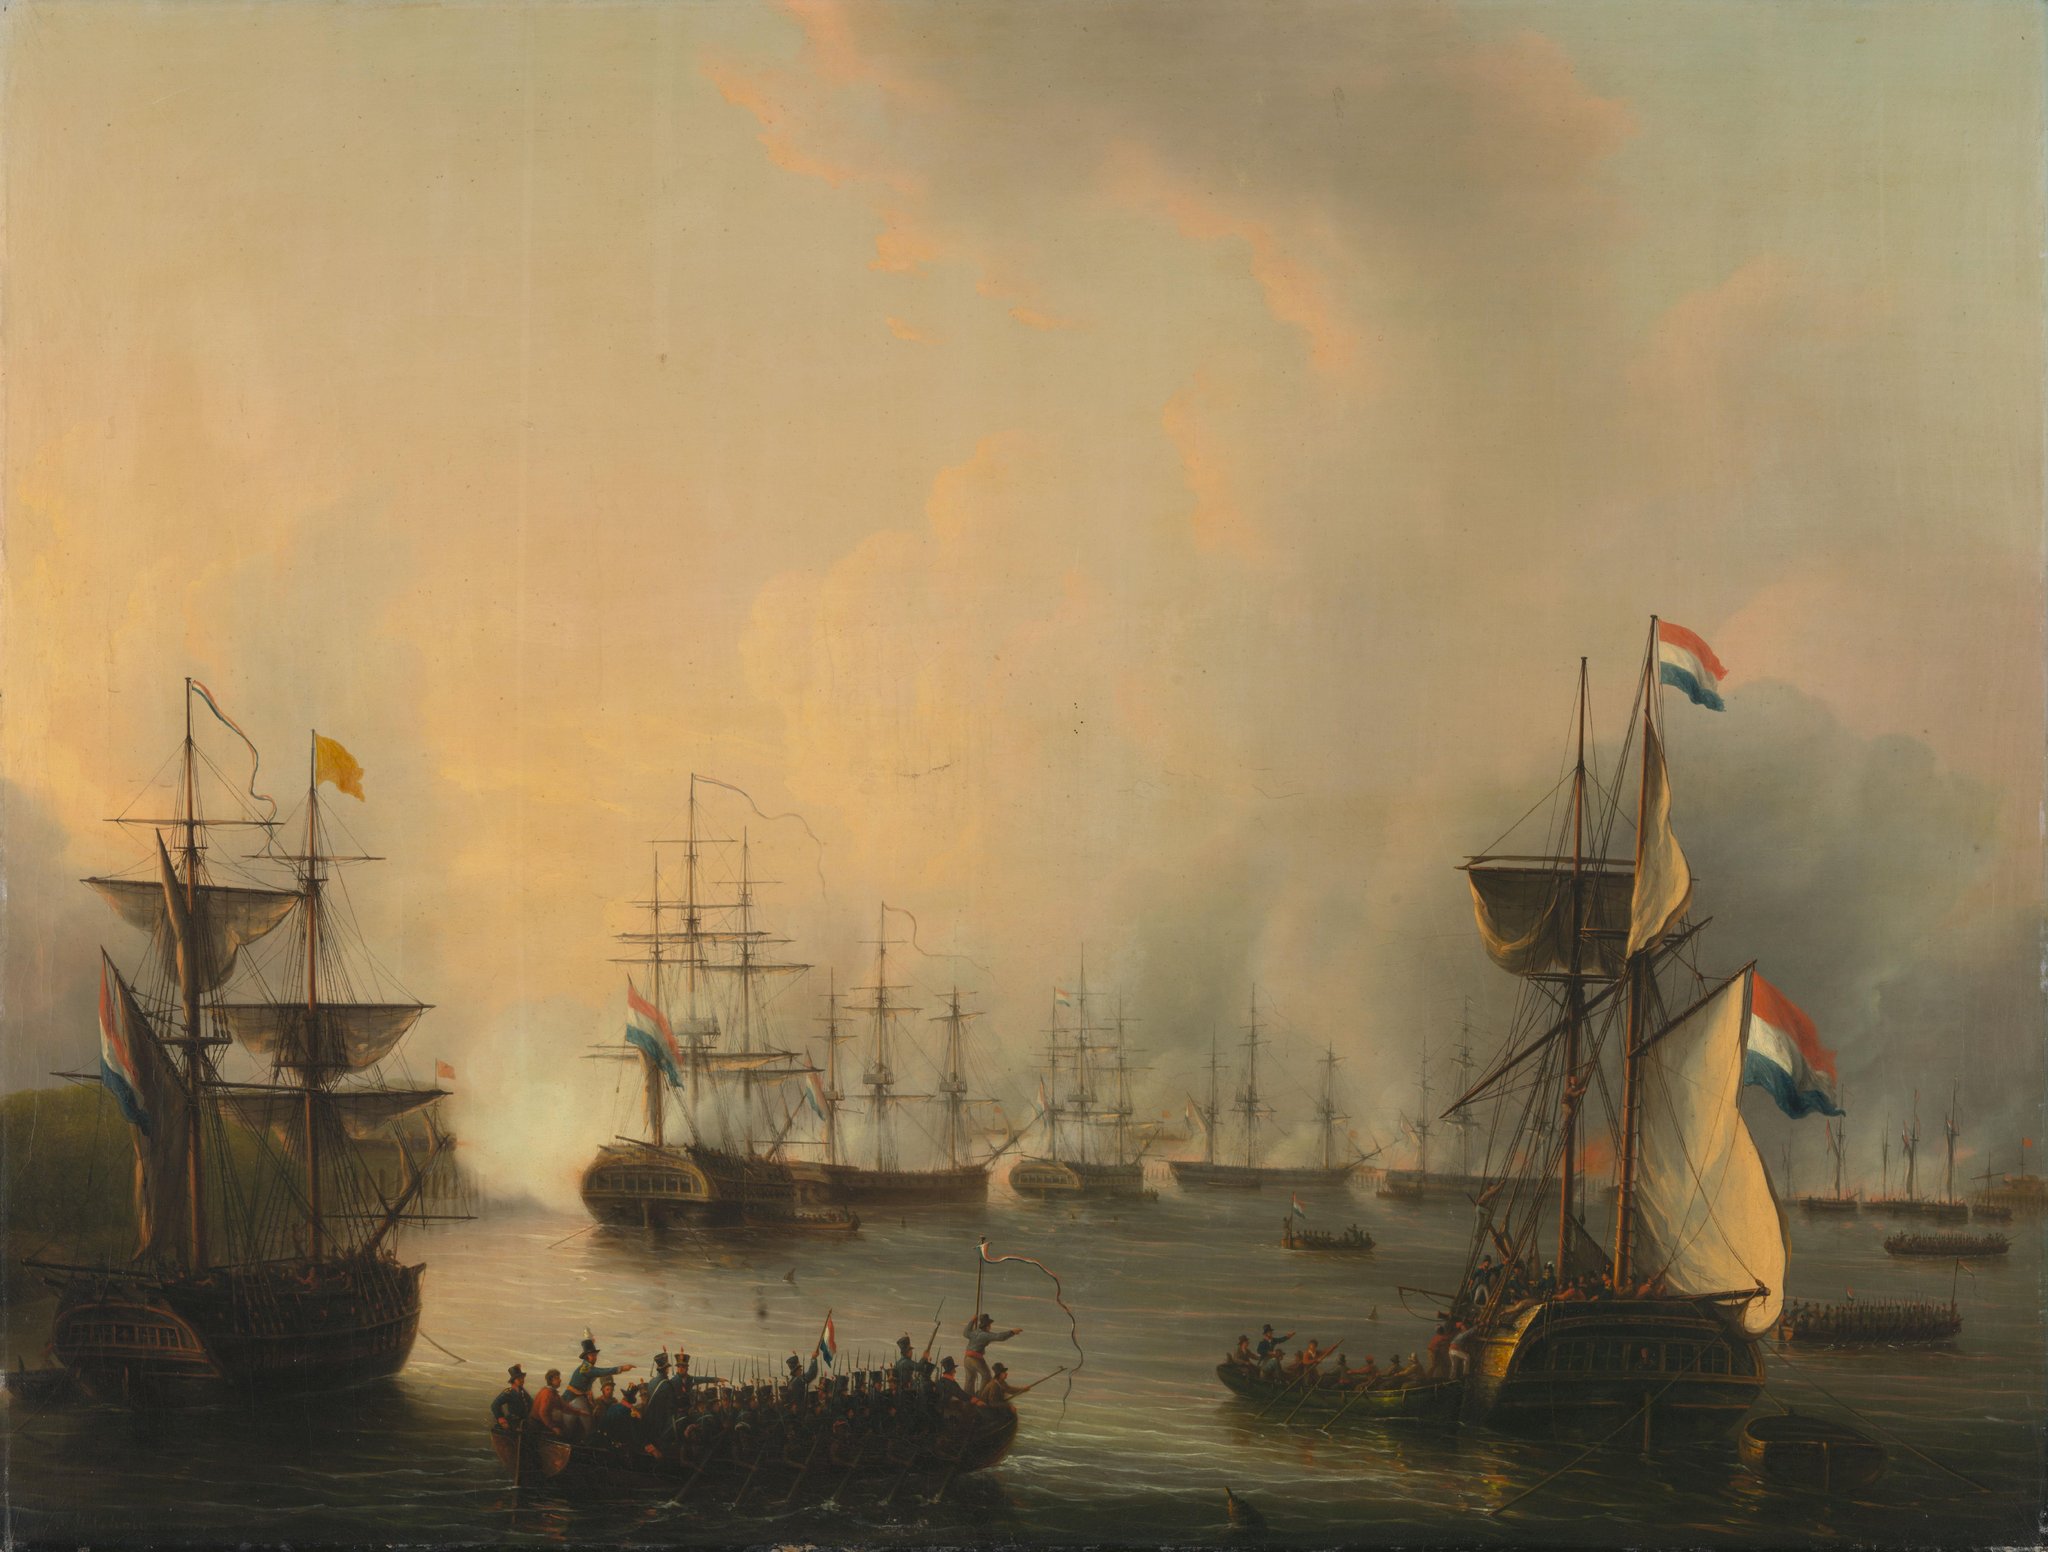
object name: painting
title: The Bombardment of Palembang, Sumatra, 24 June 1821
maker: martinus schouman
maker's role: draughtsman, painter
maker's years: 1770-1848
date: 1821-1848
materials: canvas, oil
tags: sailing-ship, sailing-boat, (military) attack (+ sailing-ships), navy, palembang (city)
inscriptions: signature: ‘M. Schouman’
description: De beschieting van Palembang op Sumatra op 24 juni 1821 door de Nederlandse vloot. De Nederlandse oorlogsschepen liggen voor de kust van Sumatra, tussen de schepen varen enkele sloepen.